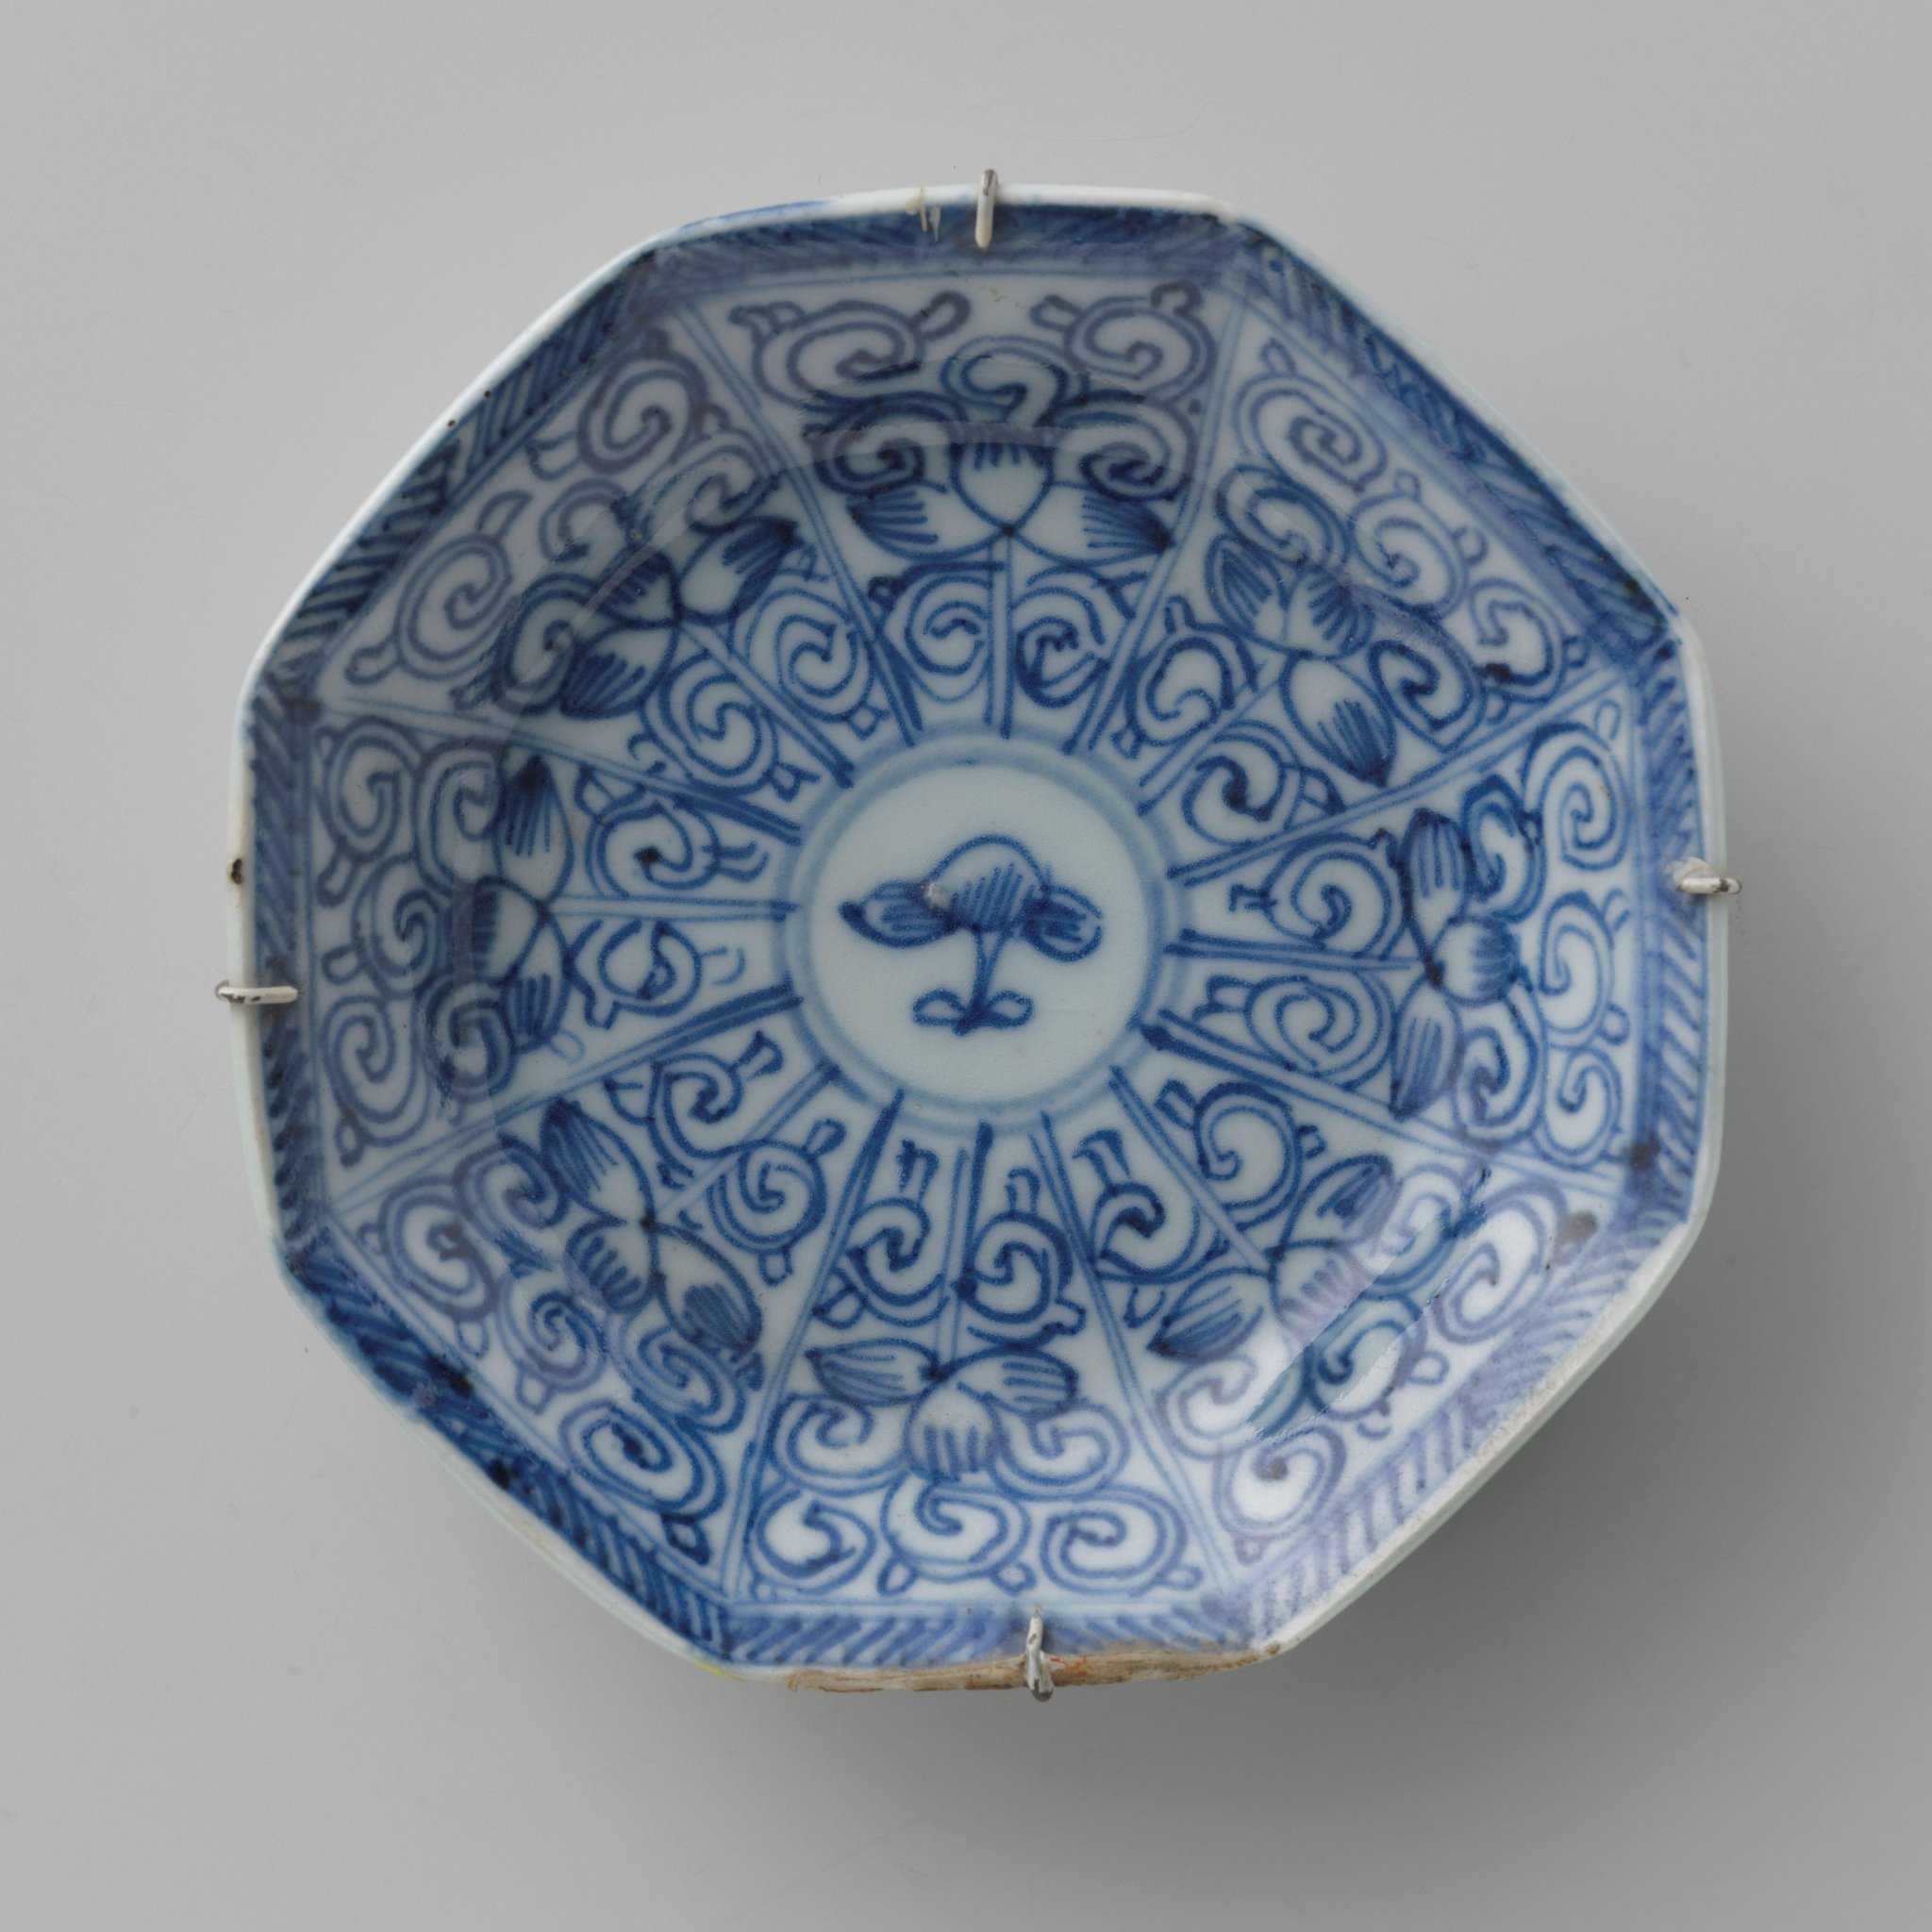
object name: platter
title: Octagonal saucer with flower scrolls in panel decoration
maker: Anonymous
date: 1700-1725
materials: cobalt, glaze, iron, paint, porcelain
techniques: firing, forming, turning, vitrification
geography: china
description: Schotel van porselein, achtkantig, Beschilderd in onderglazuurblauw met een symmetrisch decor van een bloem en voluuttakken